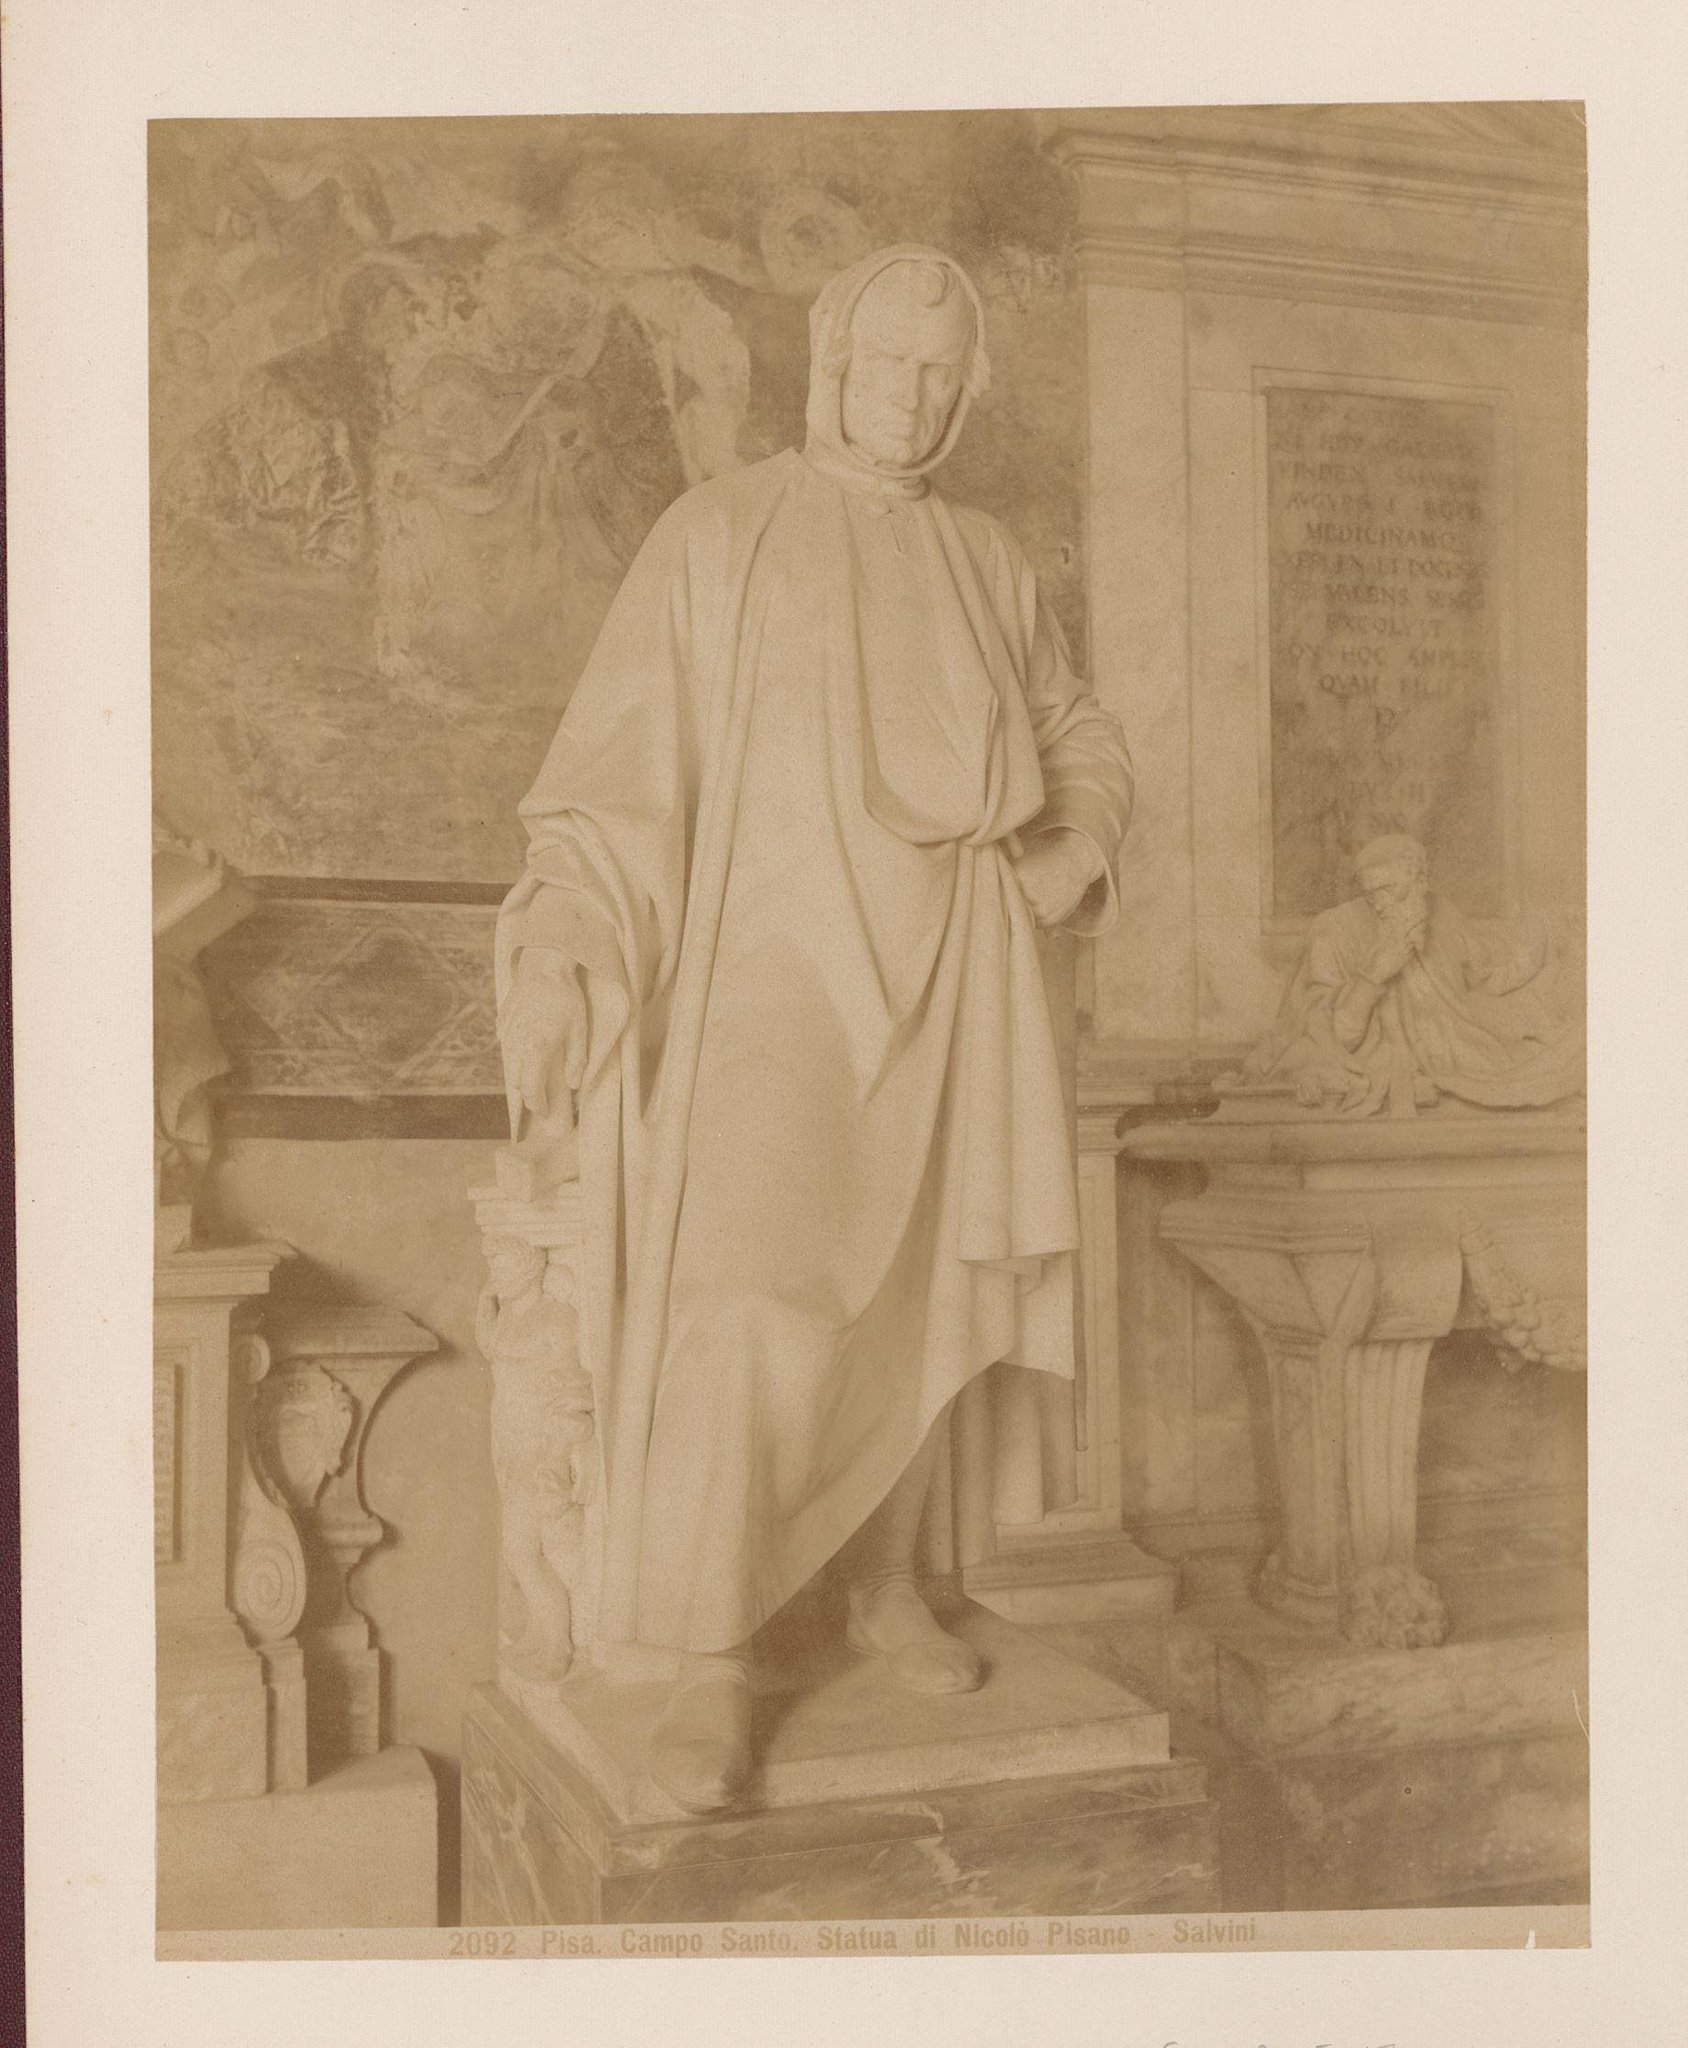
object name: photograph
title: Pisa. Campo Santo. Statua di Nicolò Pisano - Salvini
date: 1860-1881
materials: paper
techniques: albumen print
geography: pisa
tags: sculptor, nicola pisano, piece of sculpture, reproduction of a piece of sculpture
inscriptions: number: ‘2092’